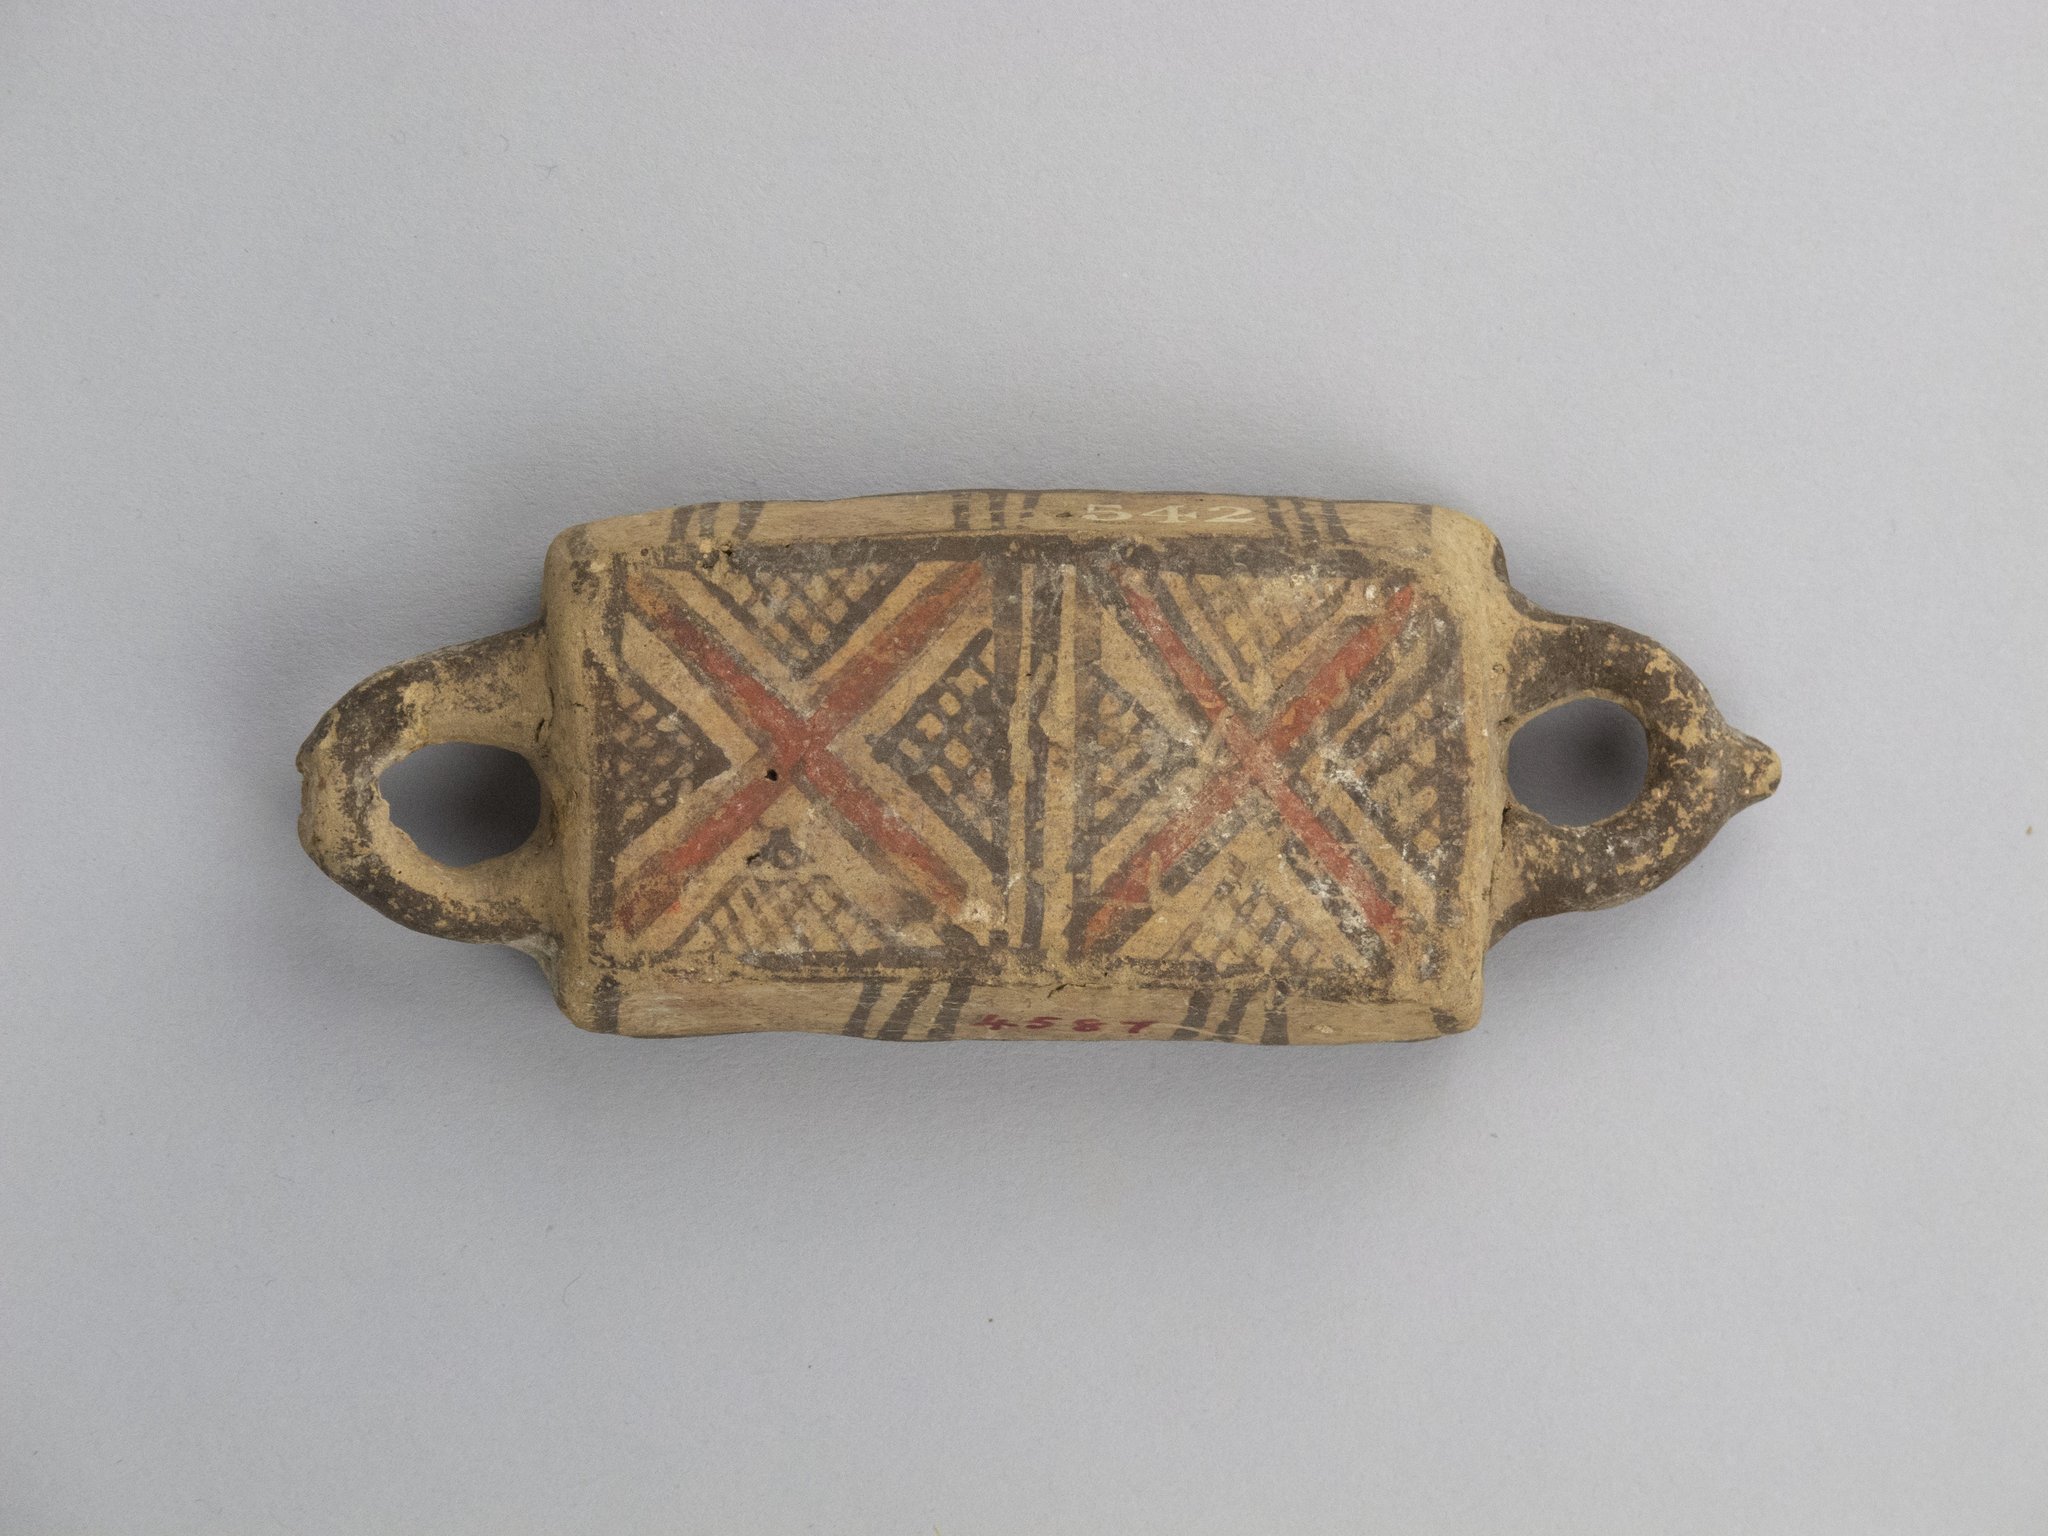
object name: tray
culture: cypriot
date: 1125-1050 BCE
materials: terracotta